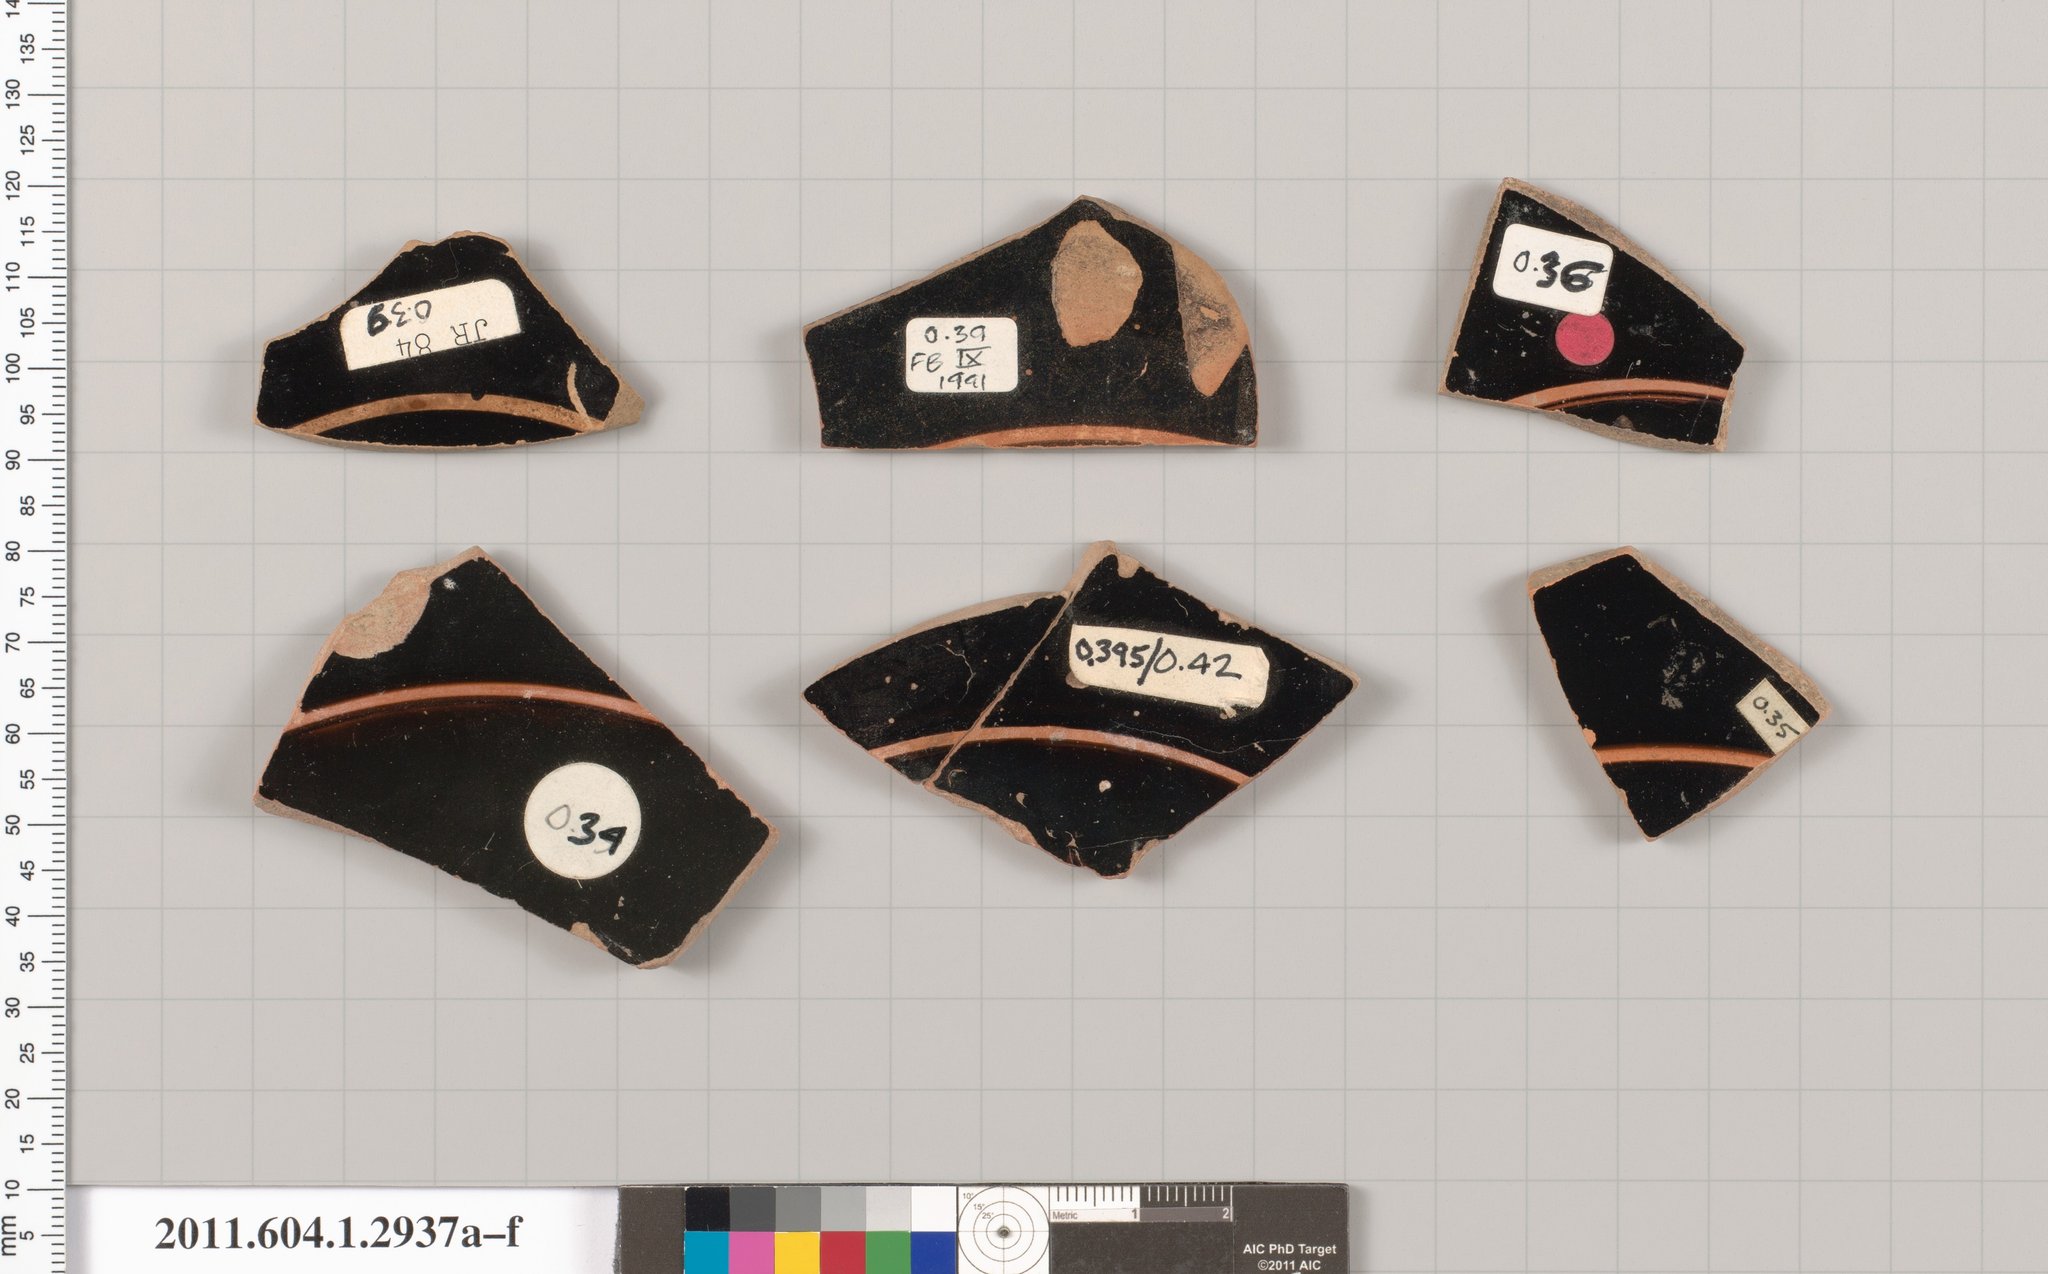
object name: kylix fragment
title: Terracotta fragments of kylikes (drinking cups)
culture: greek, attic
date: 500-476 BCE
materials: terracotta